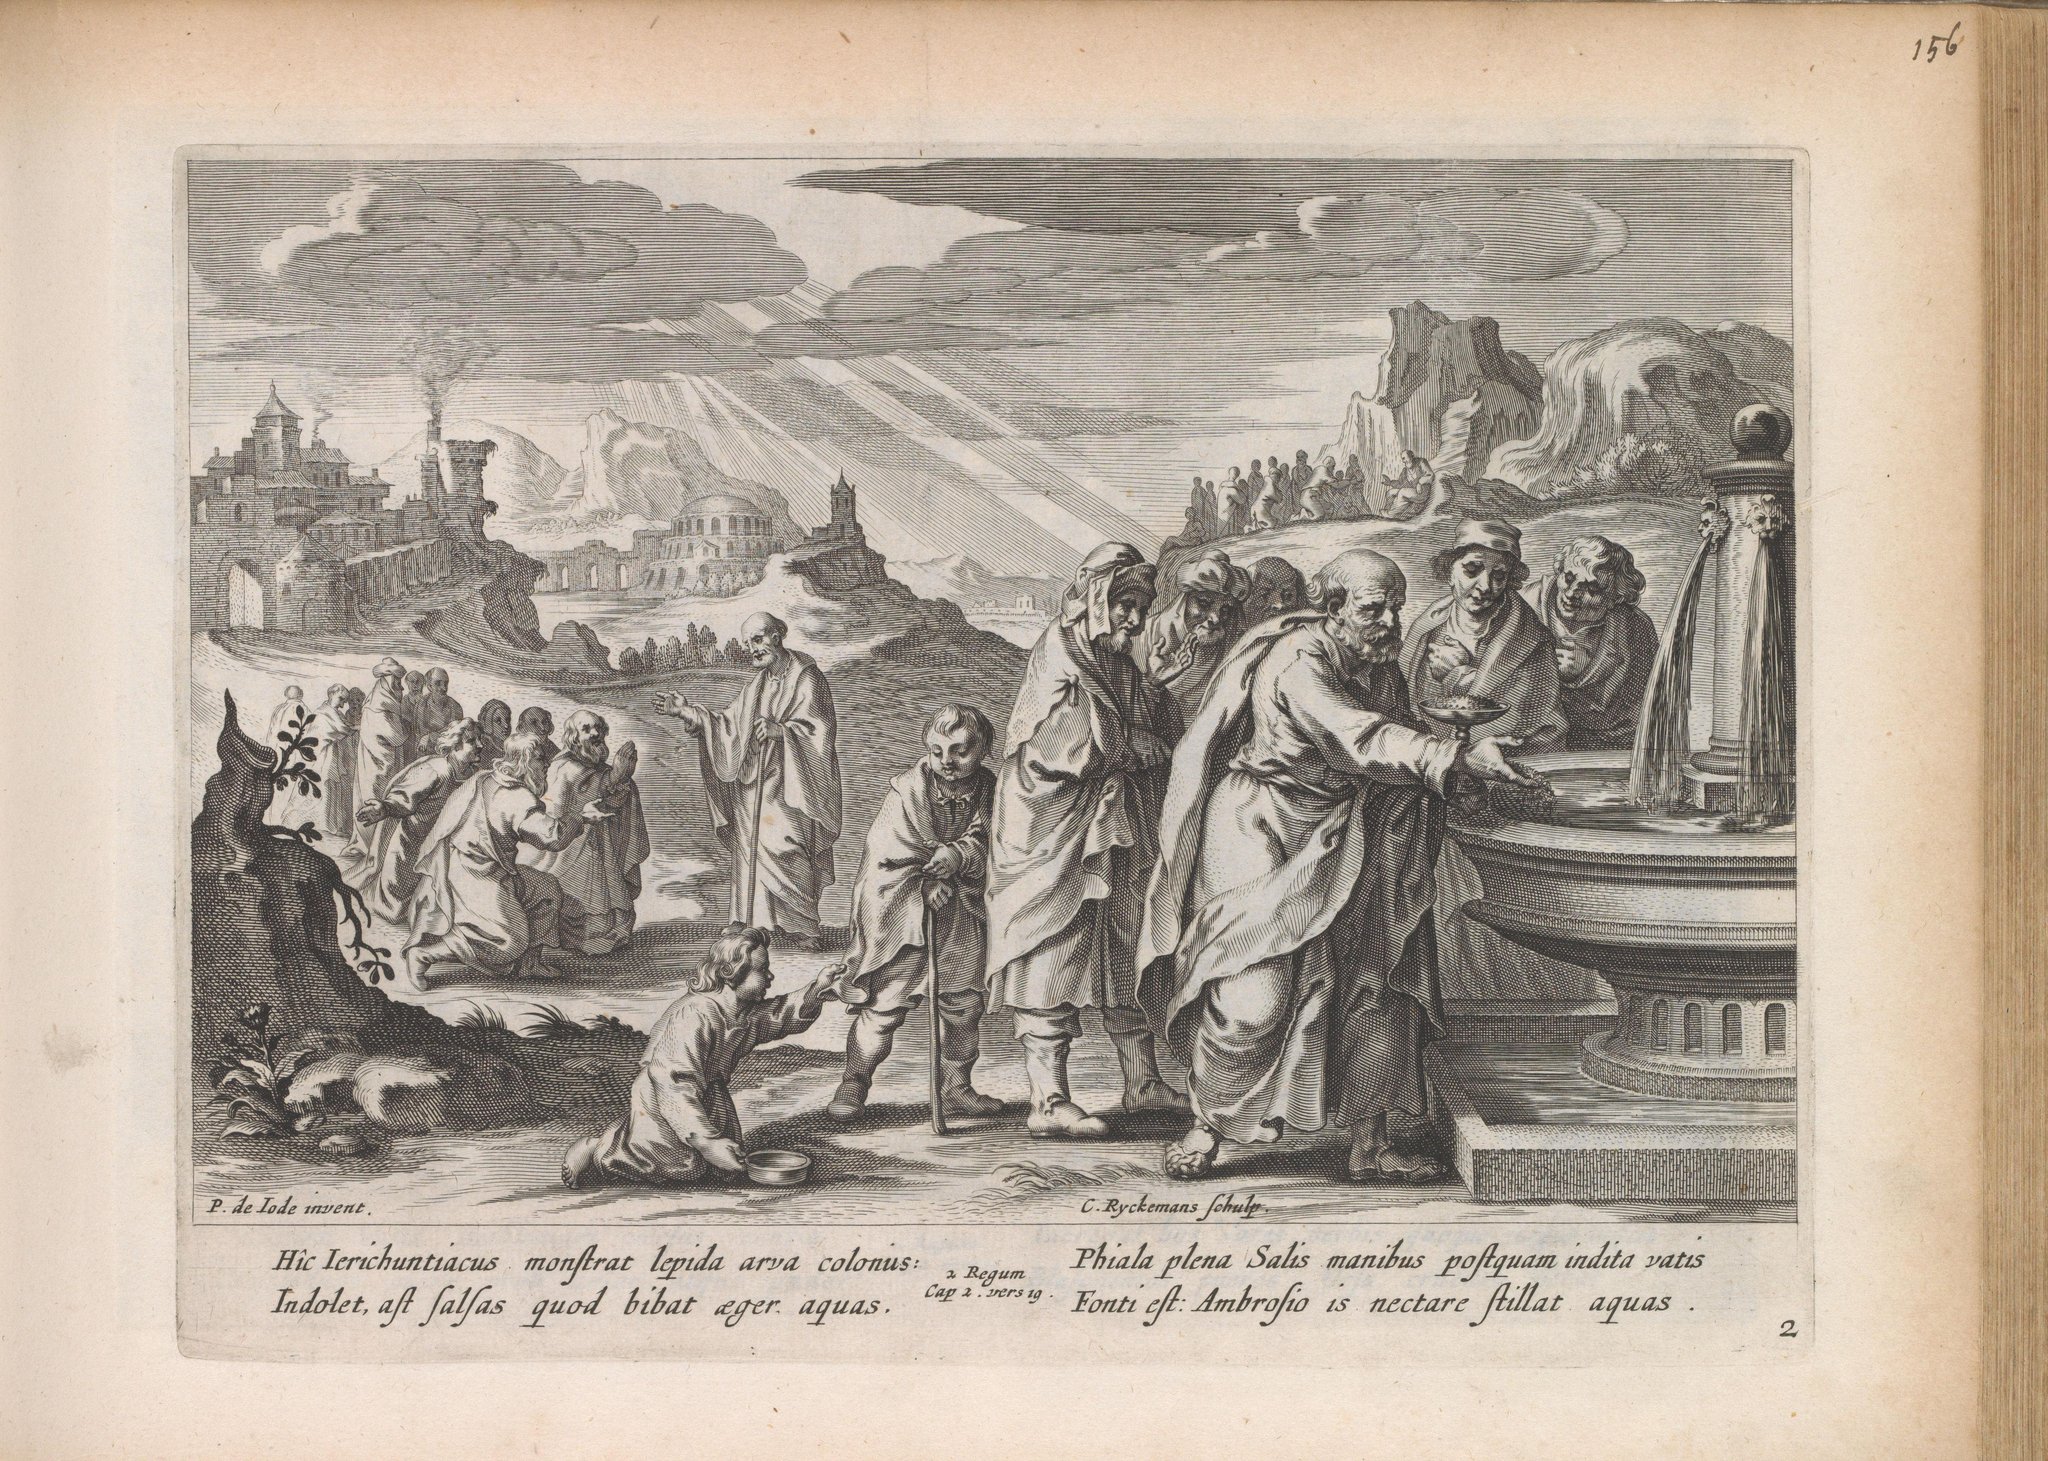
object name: album leaf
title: Geschiedenis van Elisa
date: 1616-1636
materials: paper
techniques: engraving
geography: amsterdam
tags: the water of jericho is purified: when the citizens of jericho complain about their water, elisha puts some salt into a jar; he then throws the salt into the water (2 kings 2:19-22), elisha is acknowledged as elijah's successor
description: Elisa strooit zout in de bron van Jericho om het water te zuiveren. Vanaf dat moment veroorzaakte het drinken van het bronwater geen sterfgevallen of misgeboorten meer zoals daarvoor. Op de achtergrond knielen de profeten uit Jericho voor Elisa. Onder de voorstelling een verwijzing in het Latijn naar de Bijbeltekst in 2 Kon. 2:19. Deze prent maakt deel uit van een album.